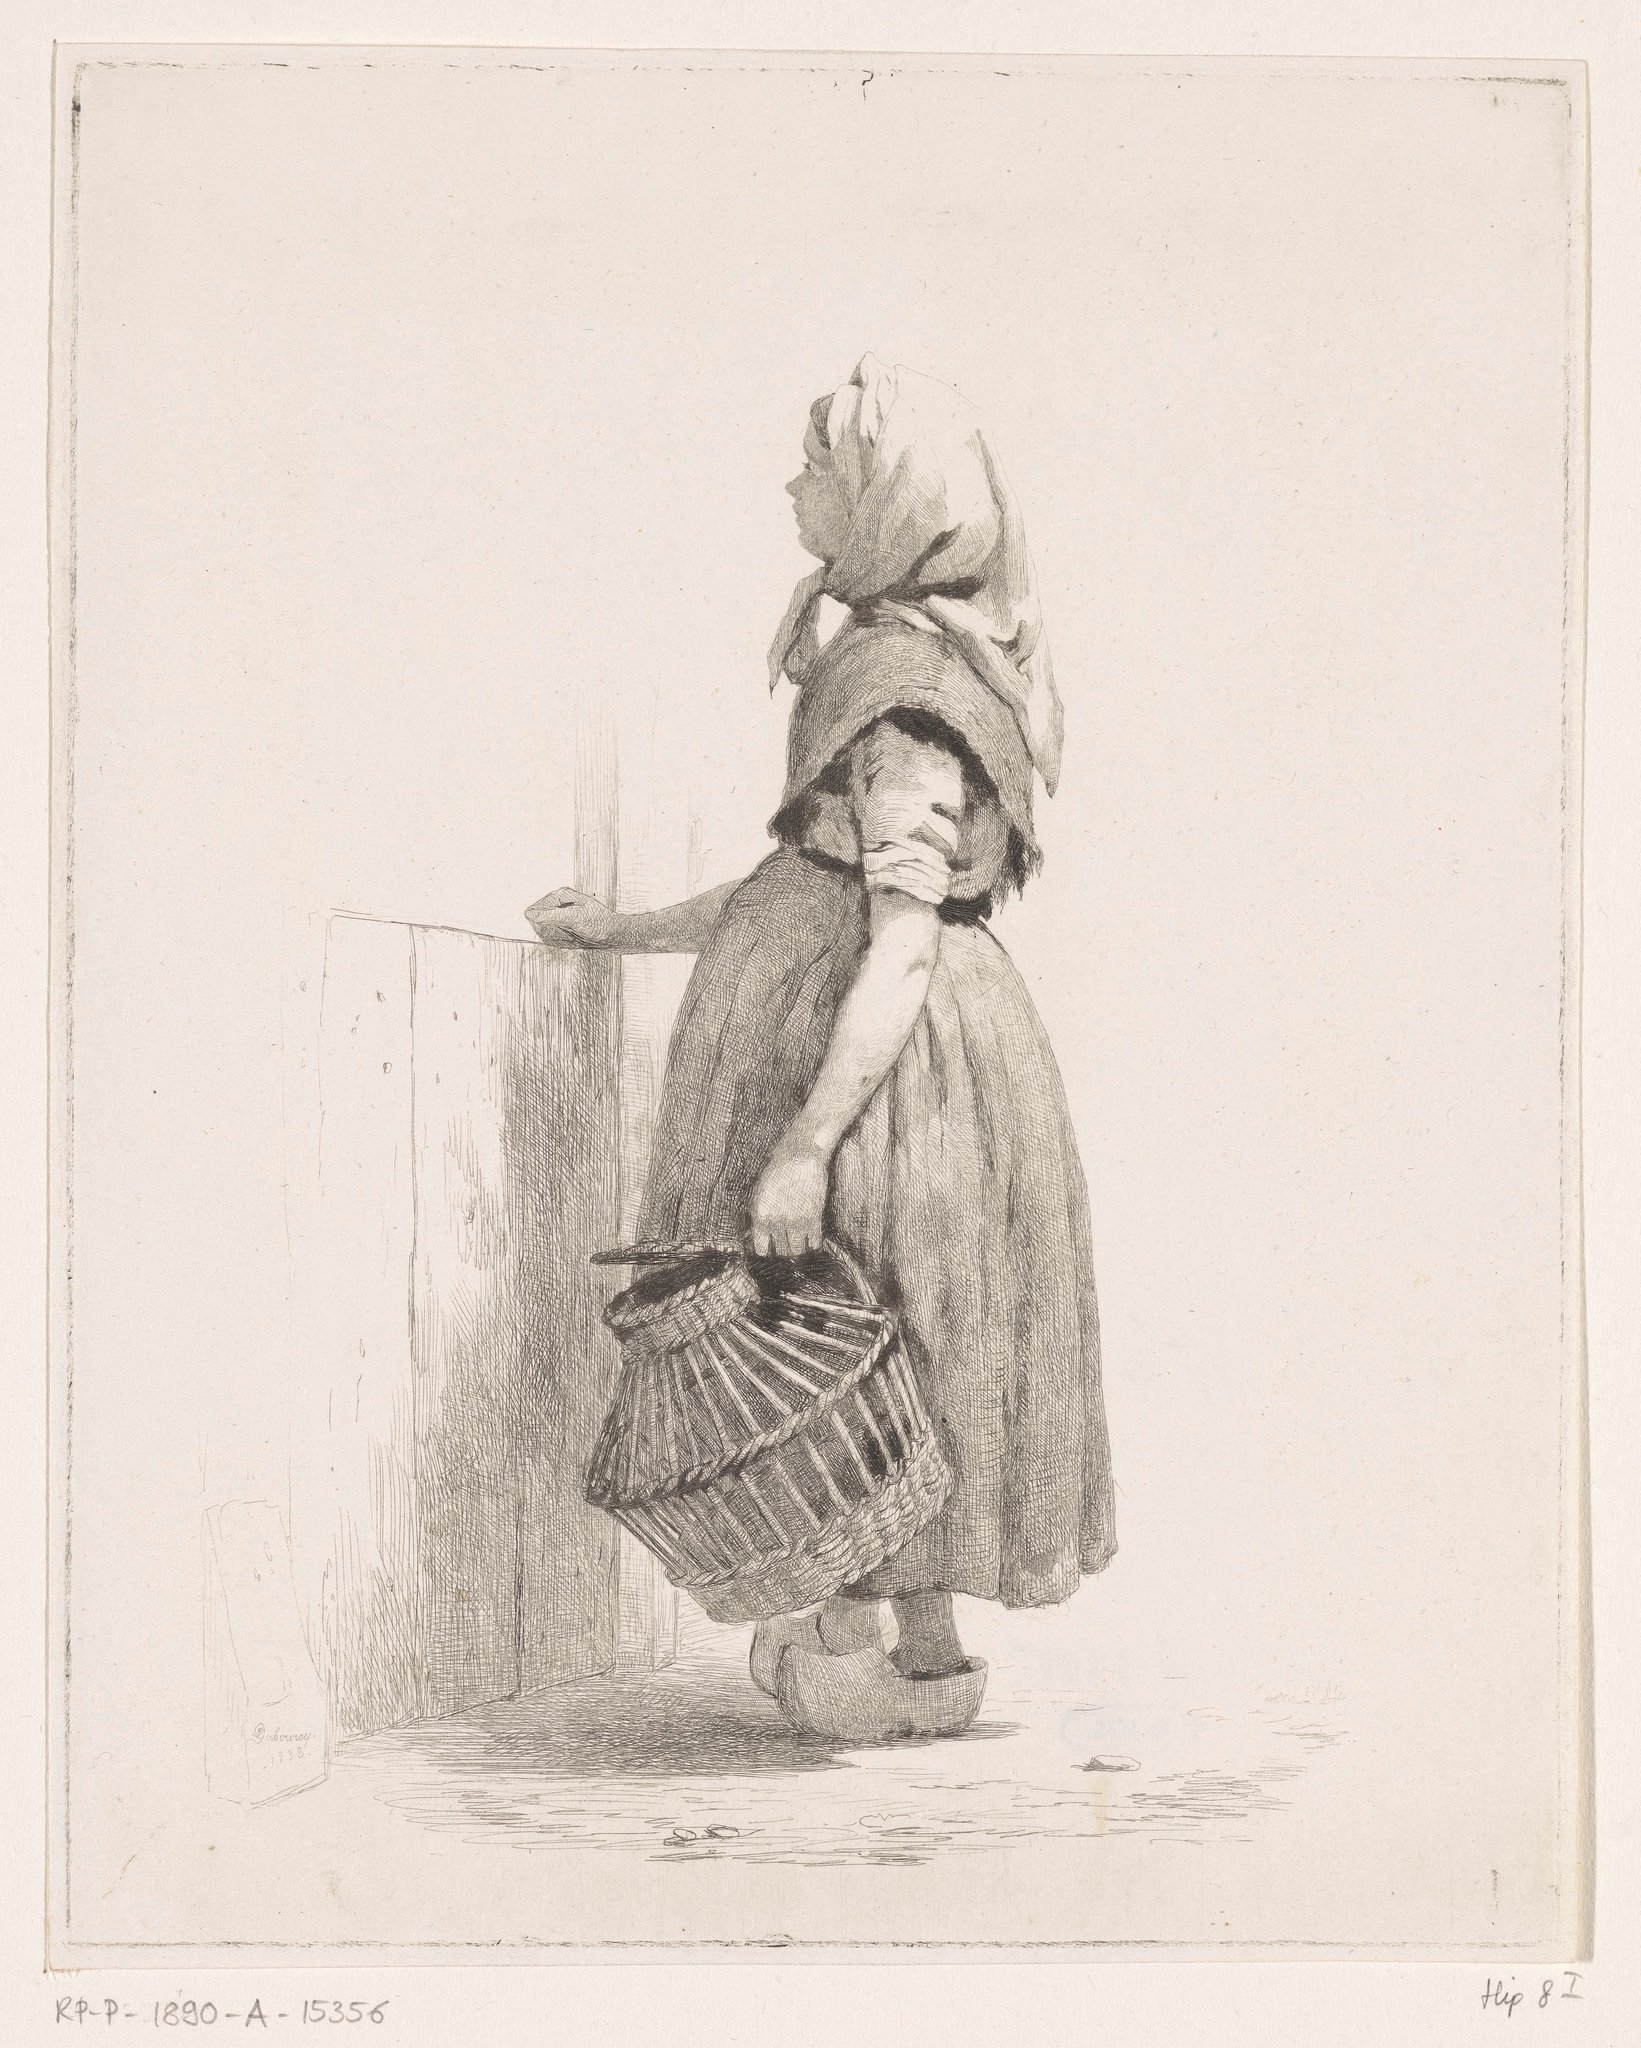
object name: print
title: Staand meisje met pluimveemand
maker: pierre louis dubourcq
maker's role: draughtsman, painter, print maker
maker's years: 1815-1873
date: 1838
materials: paper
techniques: drypoint, etching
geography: netherlands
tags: fowl (cock, hen, chicken, etc.) (+ animal cage)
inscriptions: collector's mark: Lugt 2228